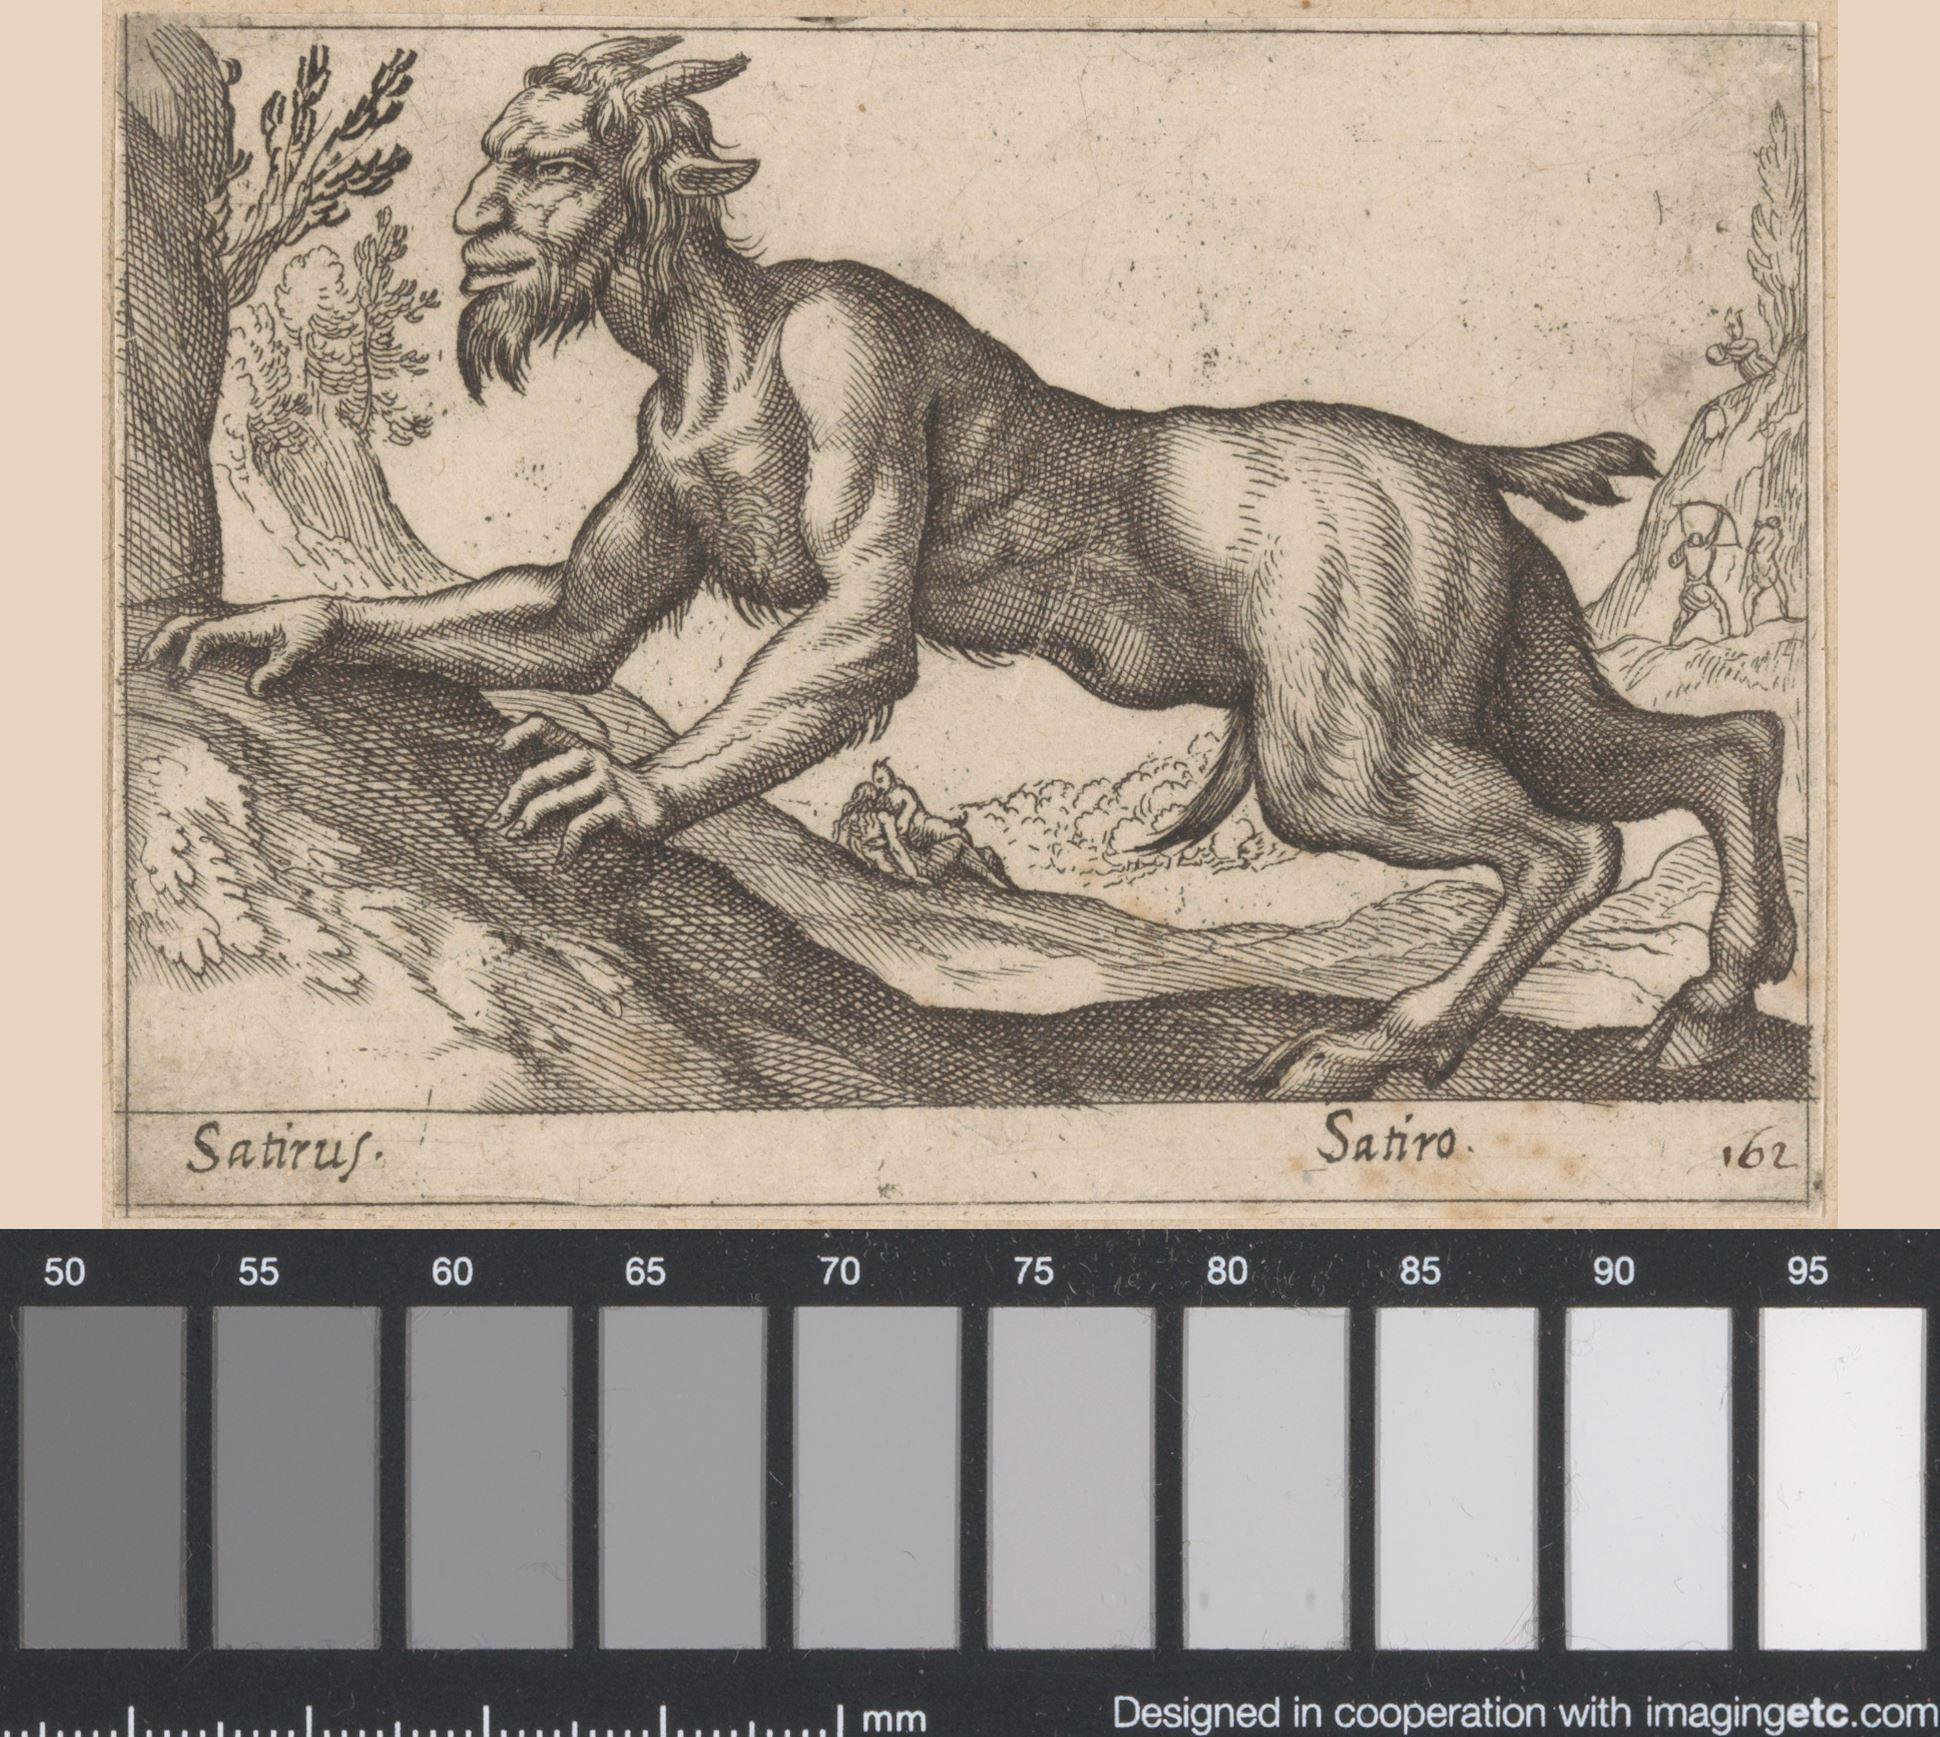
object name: print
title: Sater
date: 1565-1630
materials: paper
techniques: etching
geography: rome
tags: satyr(s) (in general)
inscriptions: collector's mark: Lugt 11, number: ‘162’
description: Deze prent maakt deel uit van een reeks prenten van dieren door Antonio Tempesta. Bekend is dat een tweede staat (met nummering) van deze serie is uitgegeven door Giovanni Giacomo de' Rossi in 1650. Onbekend is wie de eerste staat heeft uitgegeven en wanneer.